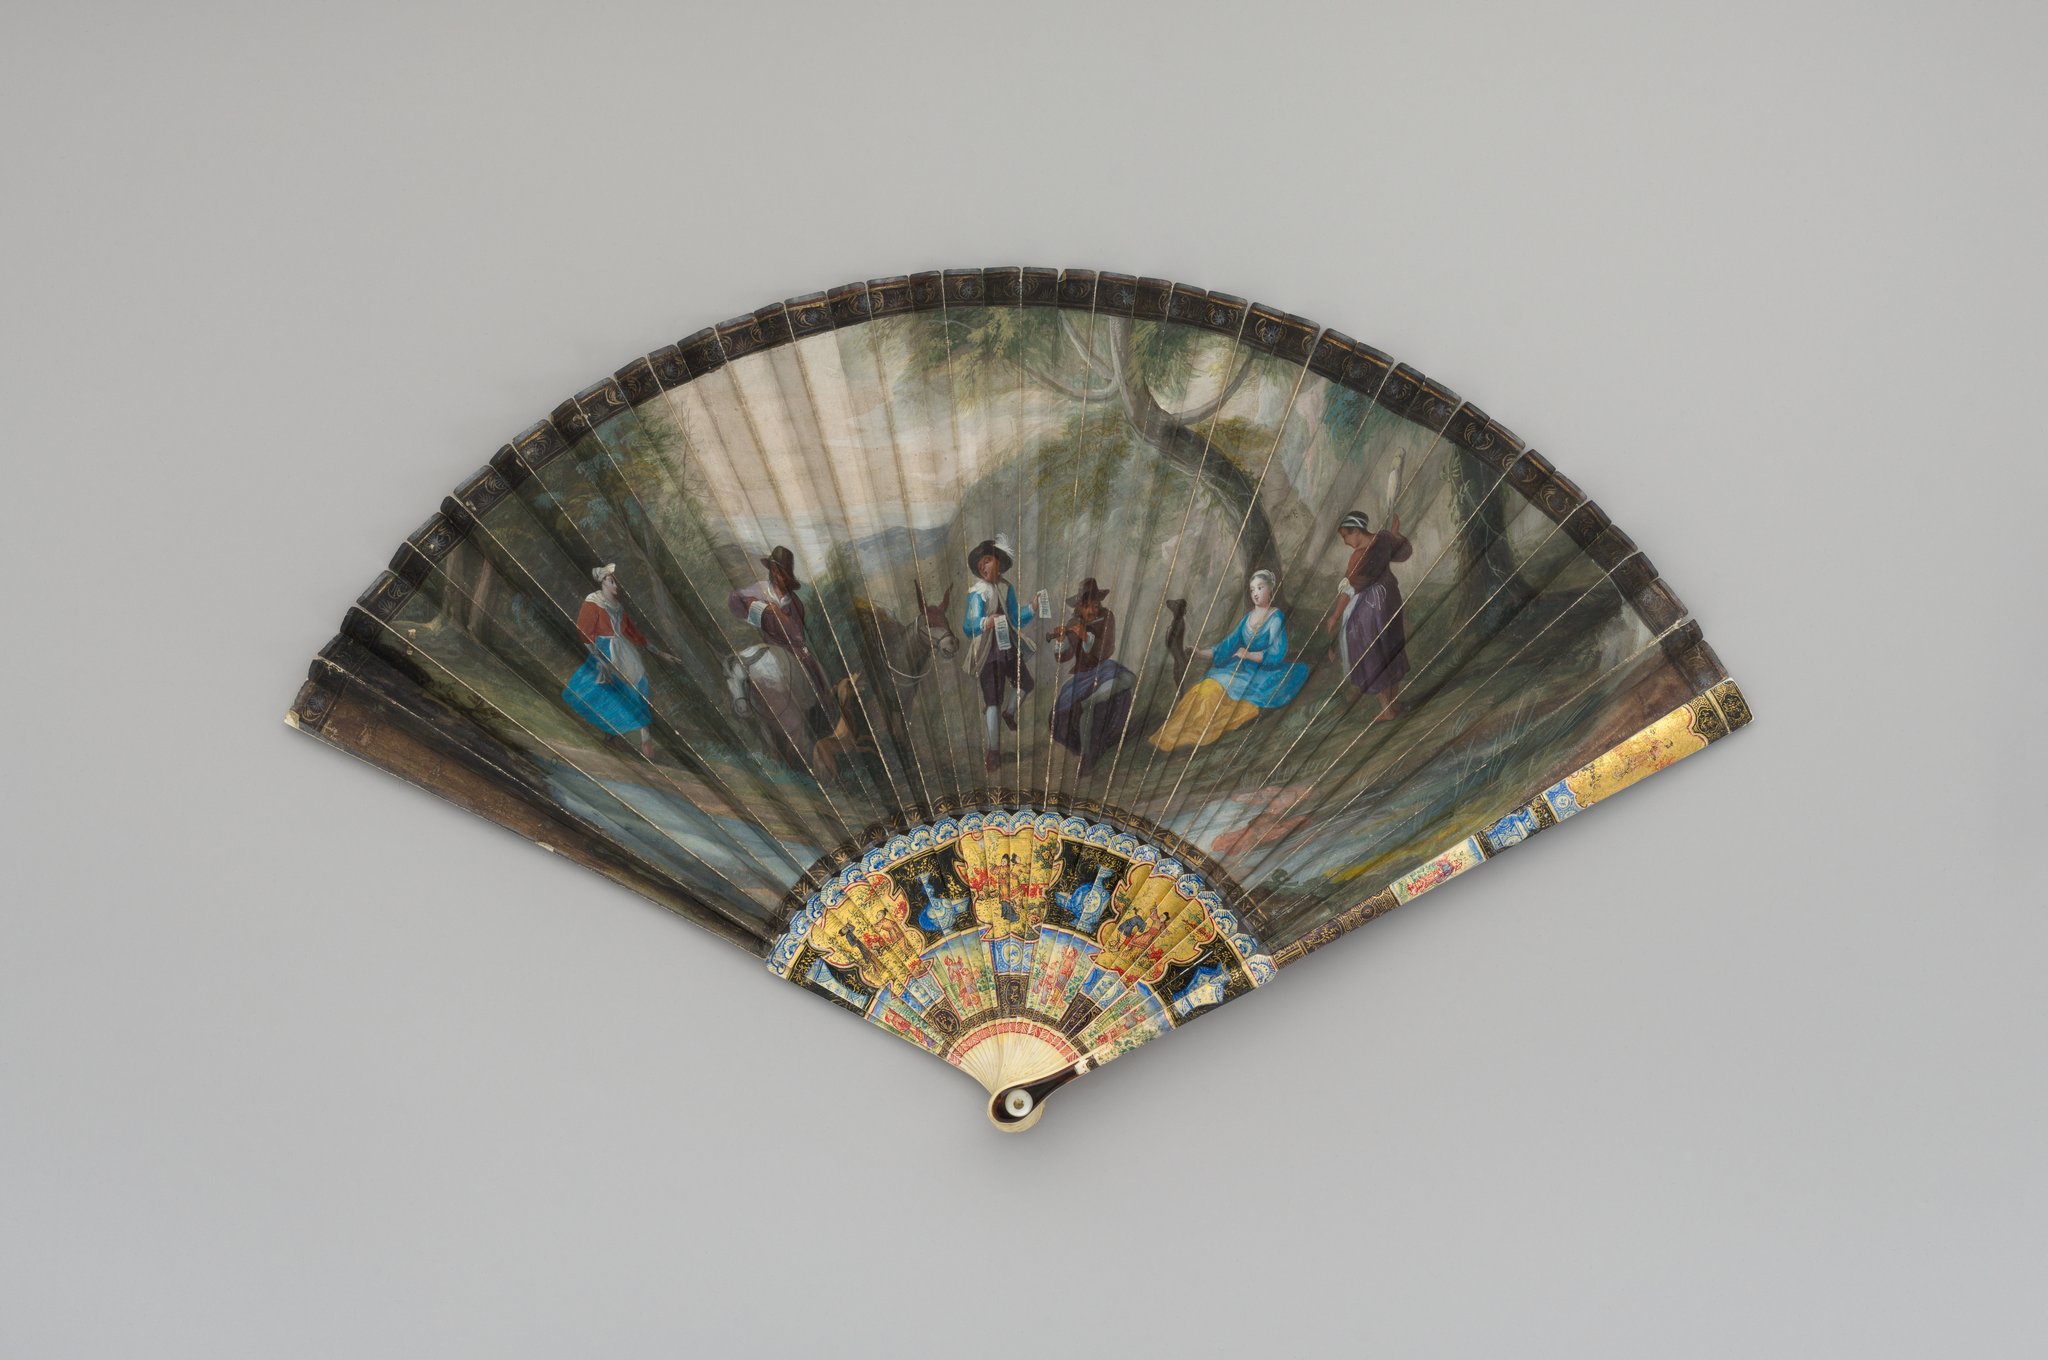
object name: fan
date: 1701-1750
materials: ivory, paper, shell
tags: men,women,lakes,boats